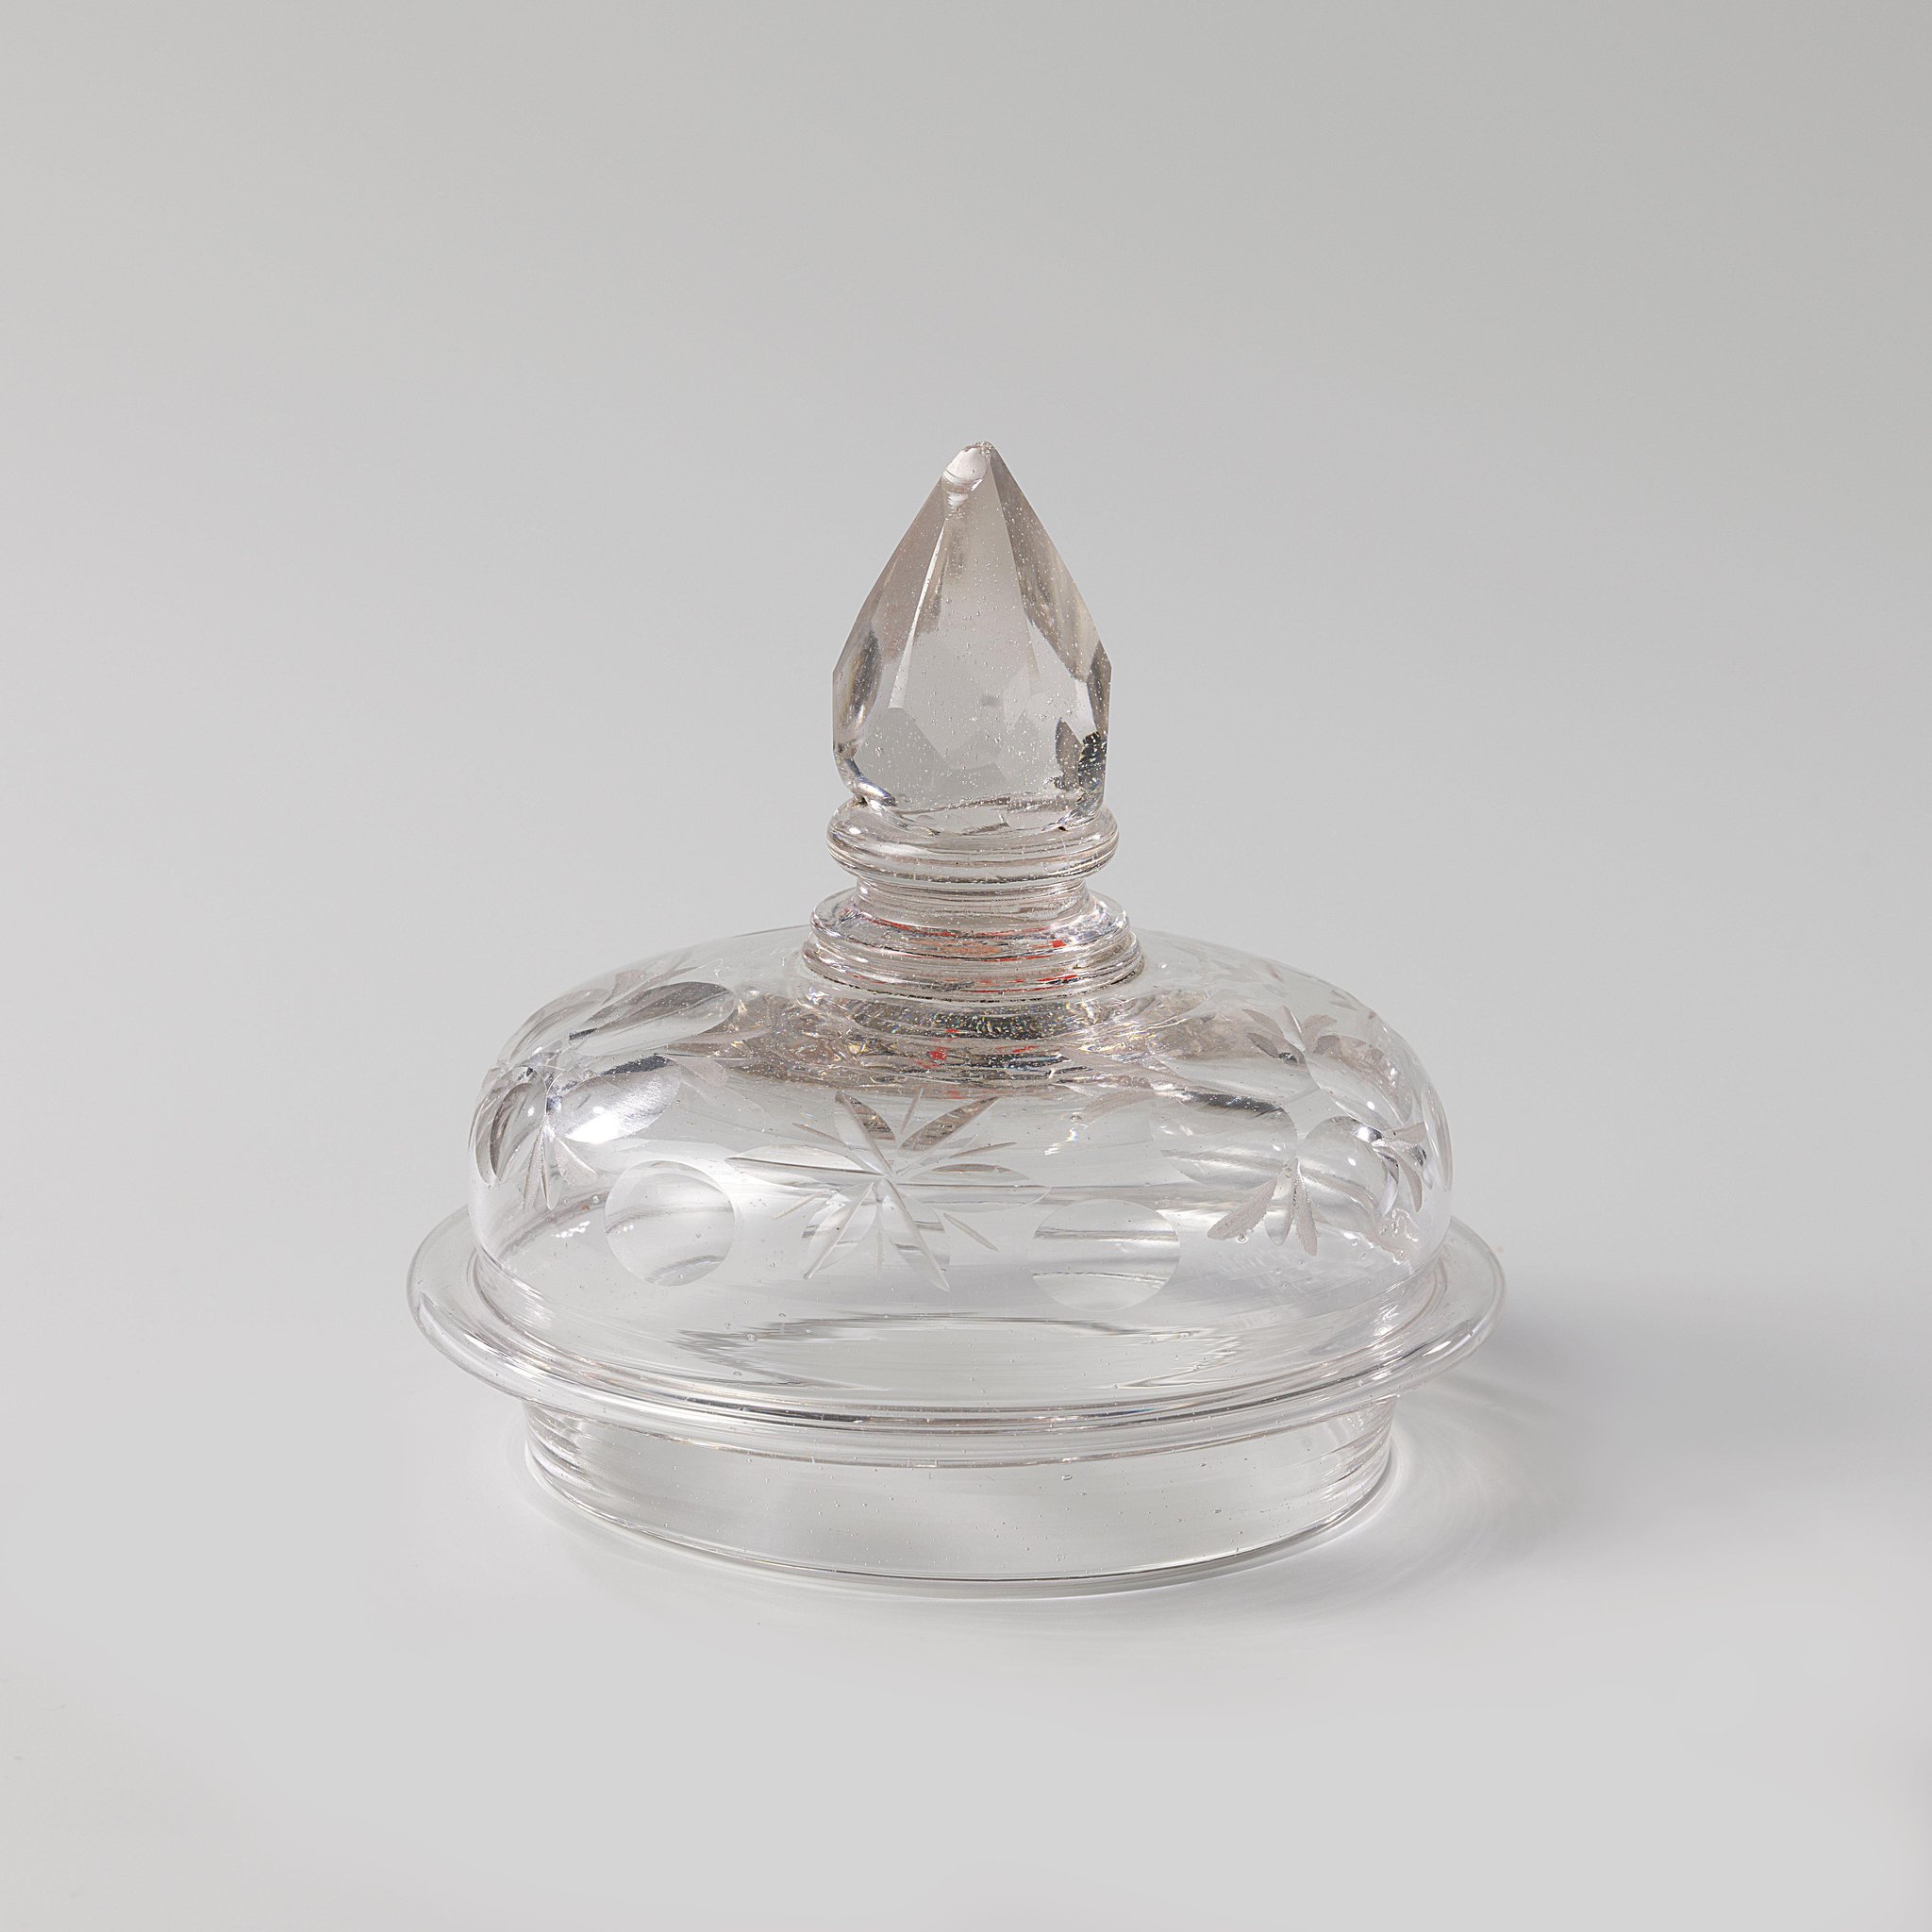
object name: lid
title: Deksel van een bokaal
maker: Anonymous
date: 1725-1750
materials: glass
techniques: glassblowing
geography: bohemia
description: Gefacetteerde, gewelfde deksel met gefacetteerde, peervormige knop op drie schijven.